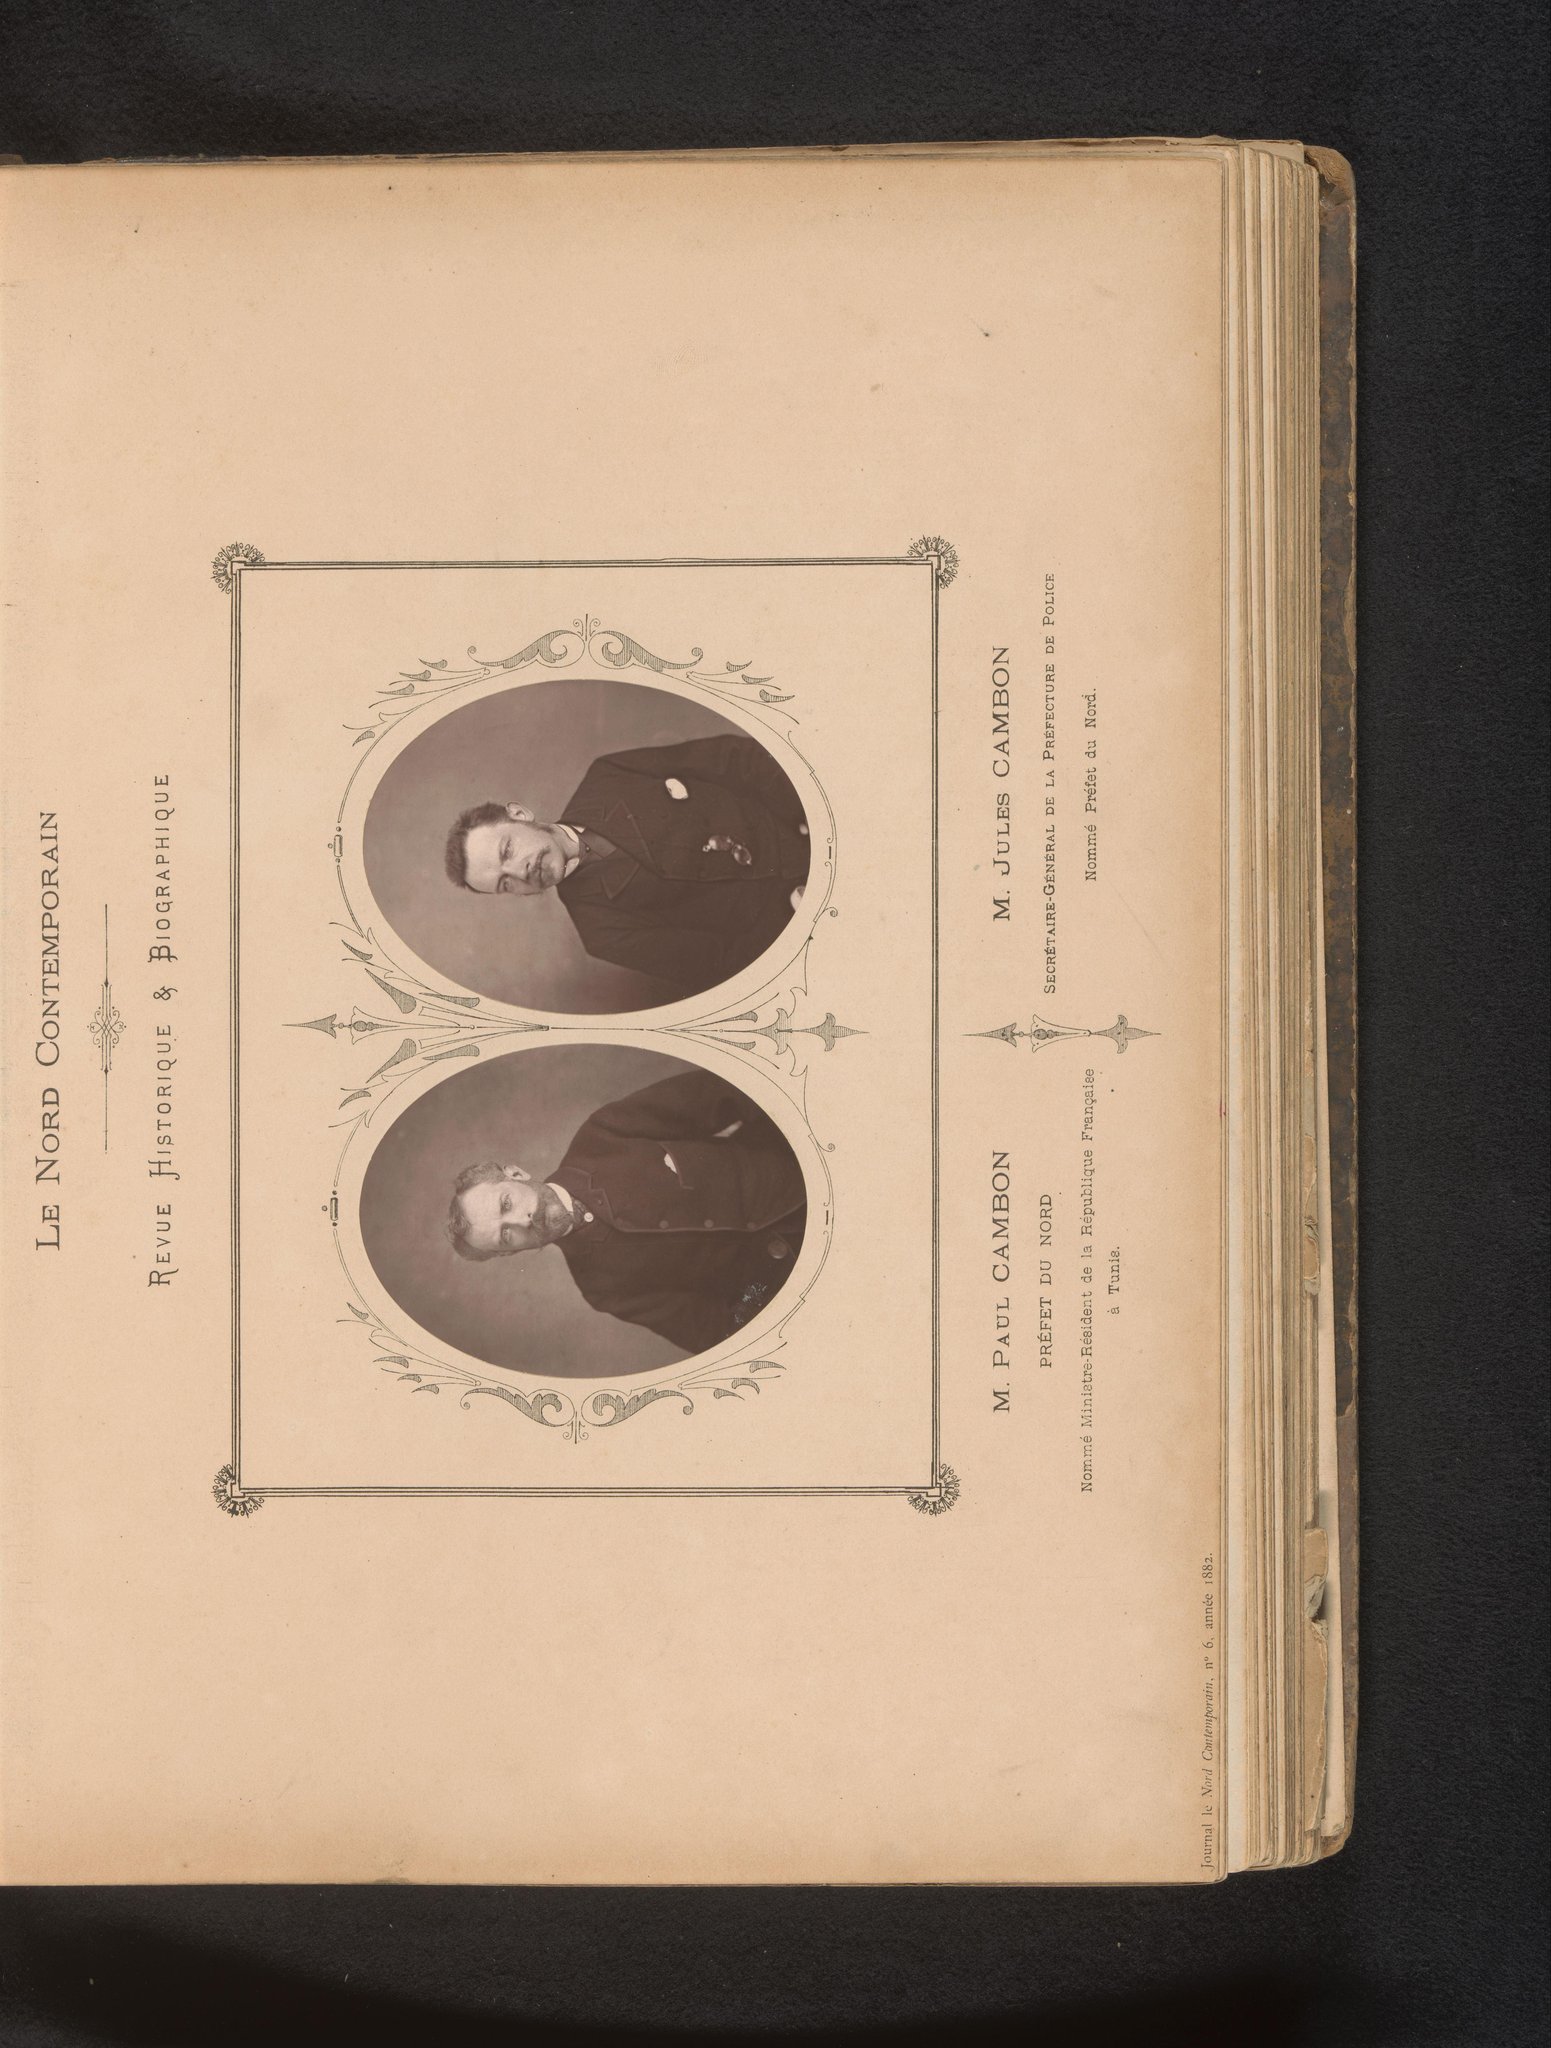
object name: page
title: M. Jules Cambon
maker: Anonymous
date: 1878-1882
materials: paper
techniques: woodburytype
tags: paris, historical persons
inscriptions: inscription: ‘Le Nord Contemporain/ Revue Historique & Biographique’, inscription: ‘Journal le Nord Contemporain, No 6, année 1882’, inscription: ‘Secrétaire-général de la préfecture de police/ Nommé Préfet du Nord’